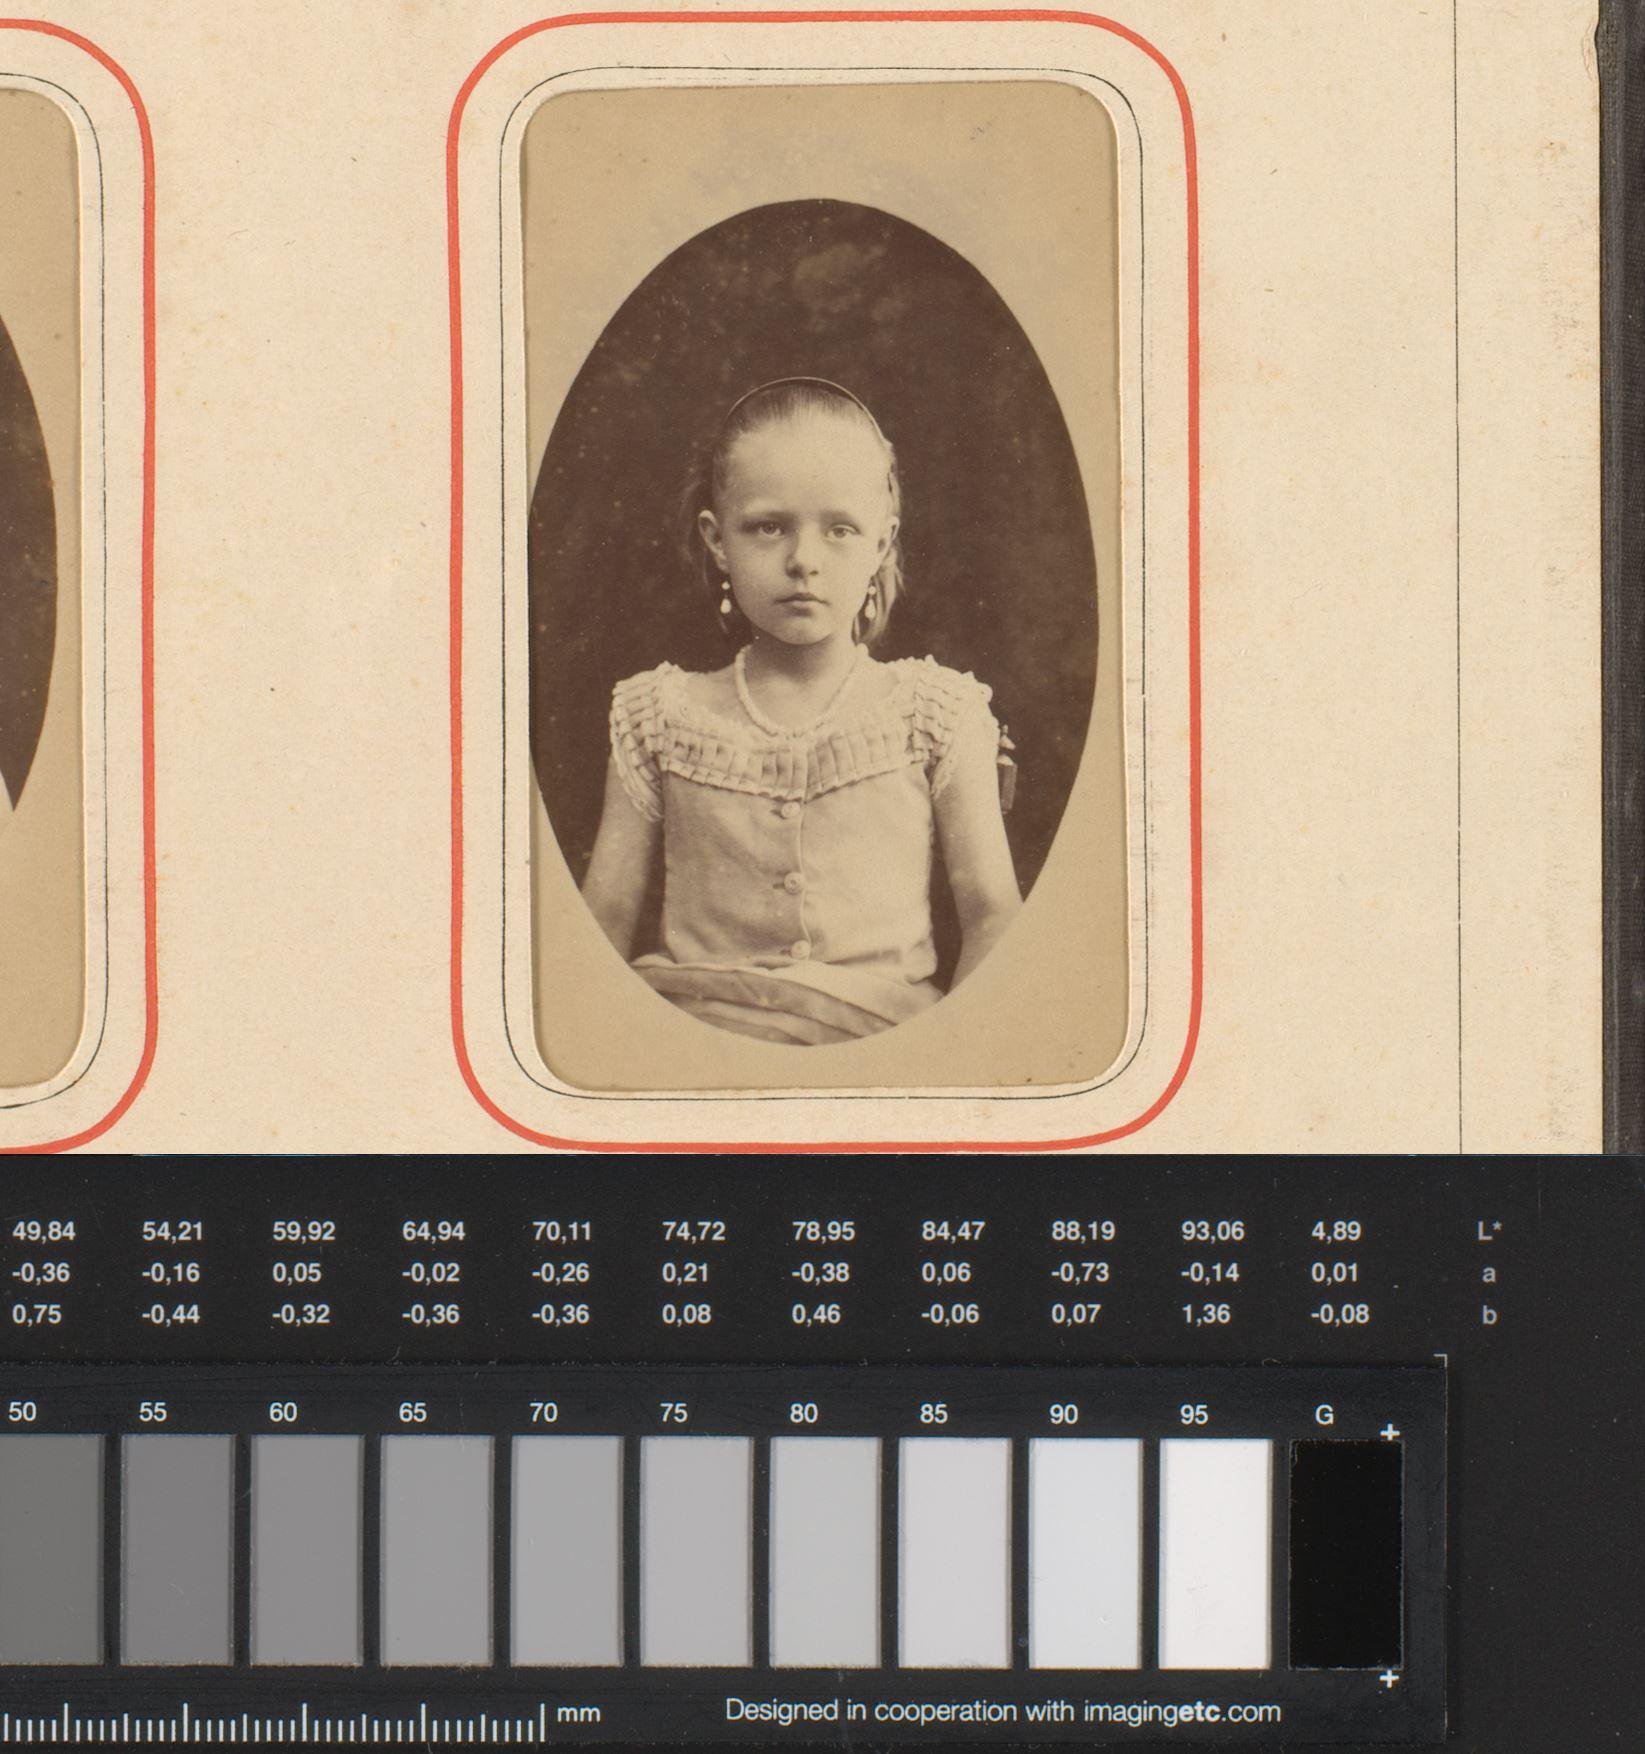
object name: photograph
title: Portret van een onbekend meisje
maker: johann von petz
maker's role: fotograaf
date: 1870-1890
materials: cardboard, paper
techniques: albumen print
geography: batavia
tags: anonymous historical person portrayed - bb - woman